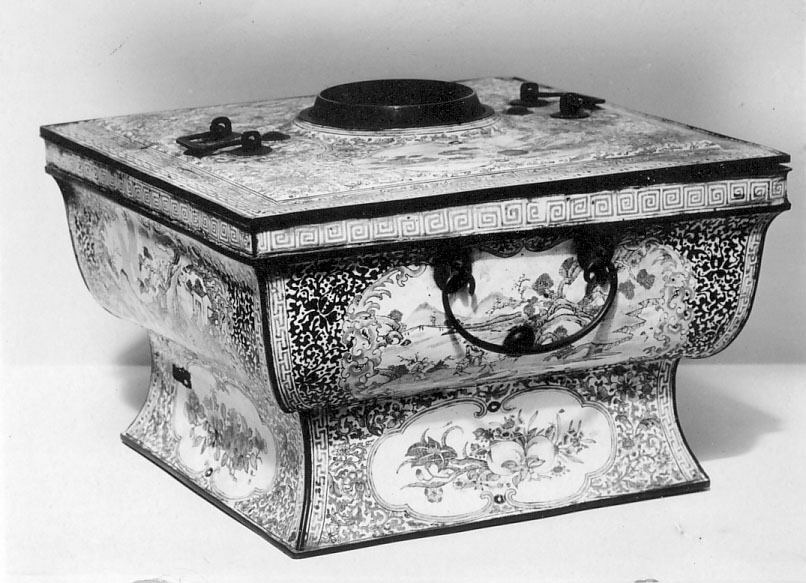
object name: steaming pan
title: Steaming-Pan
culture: chinese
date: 1701-1800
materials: enamel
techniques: painting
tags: landscapes